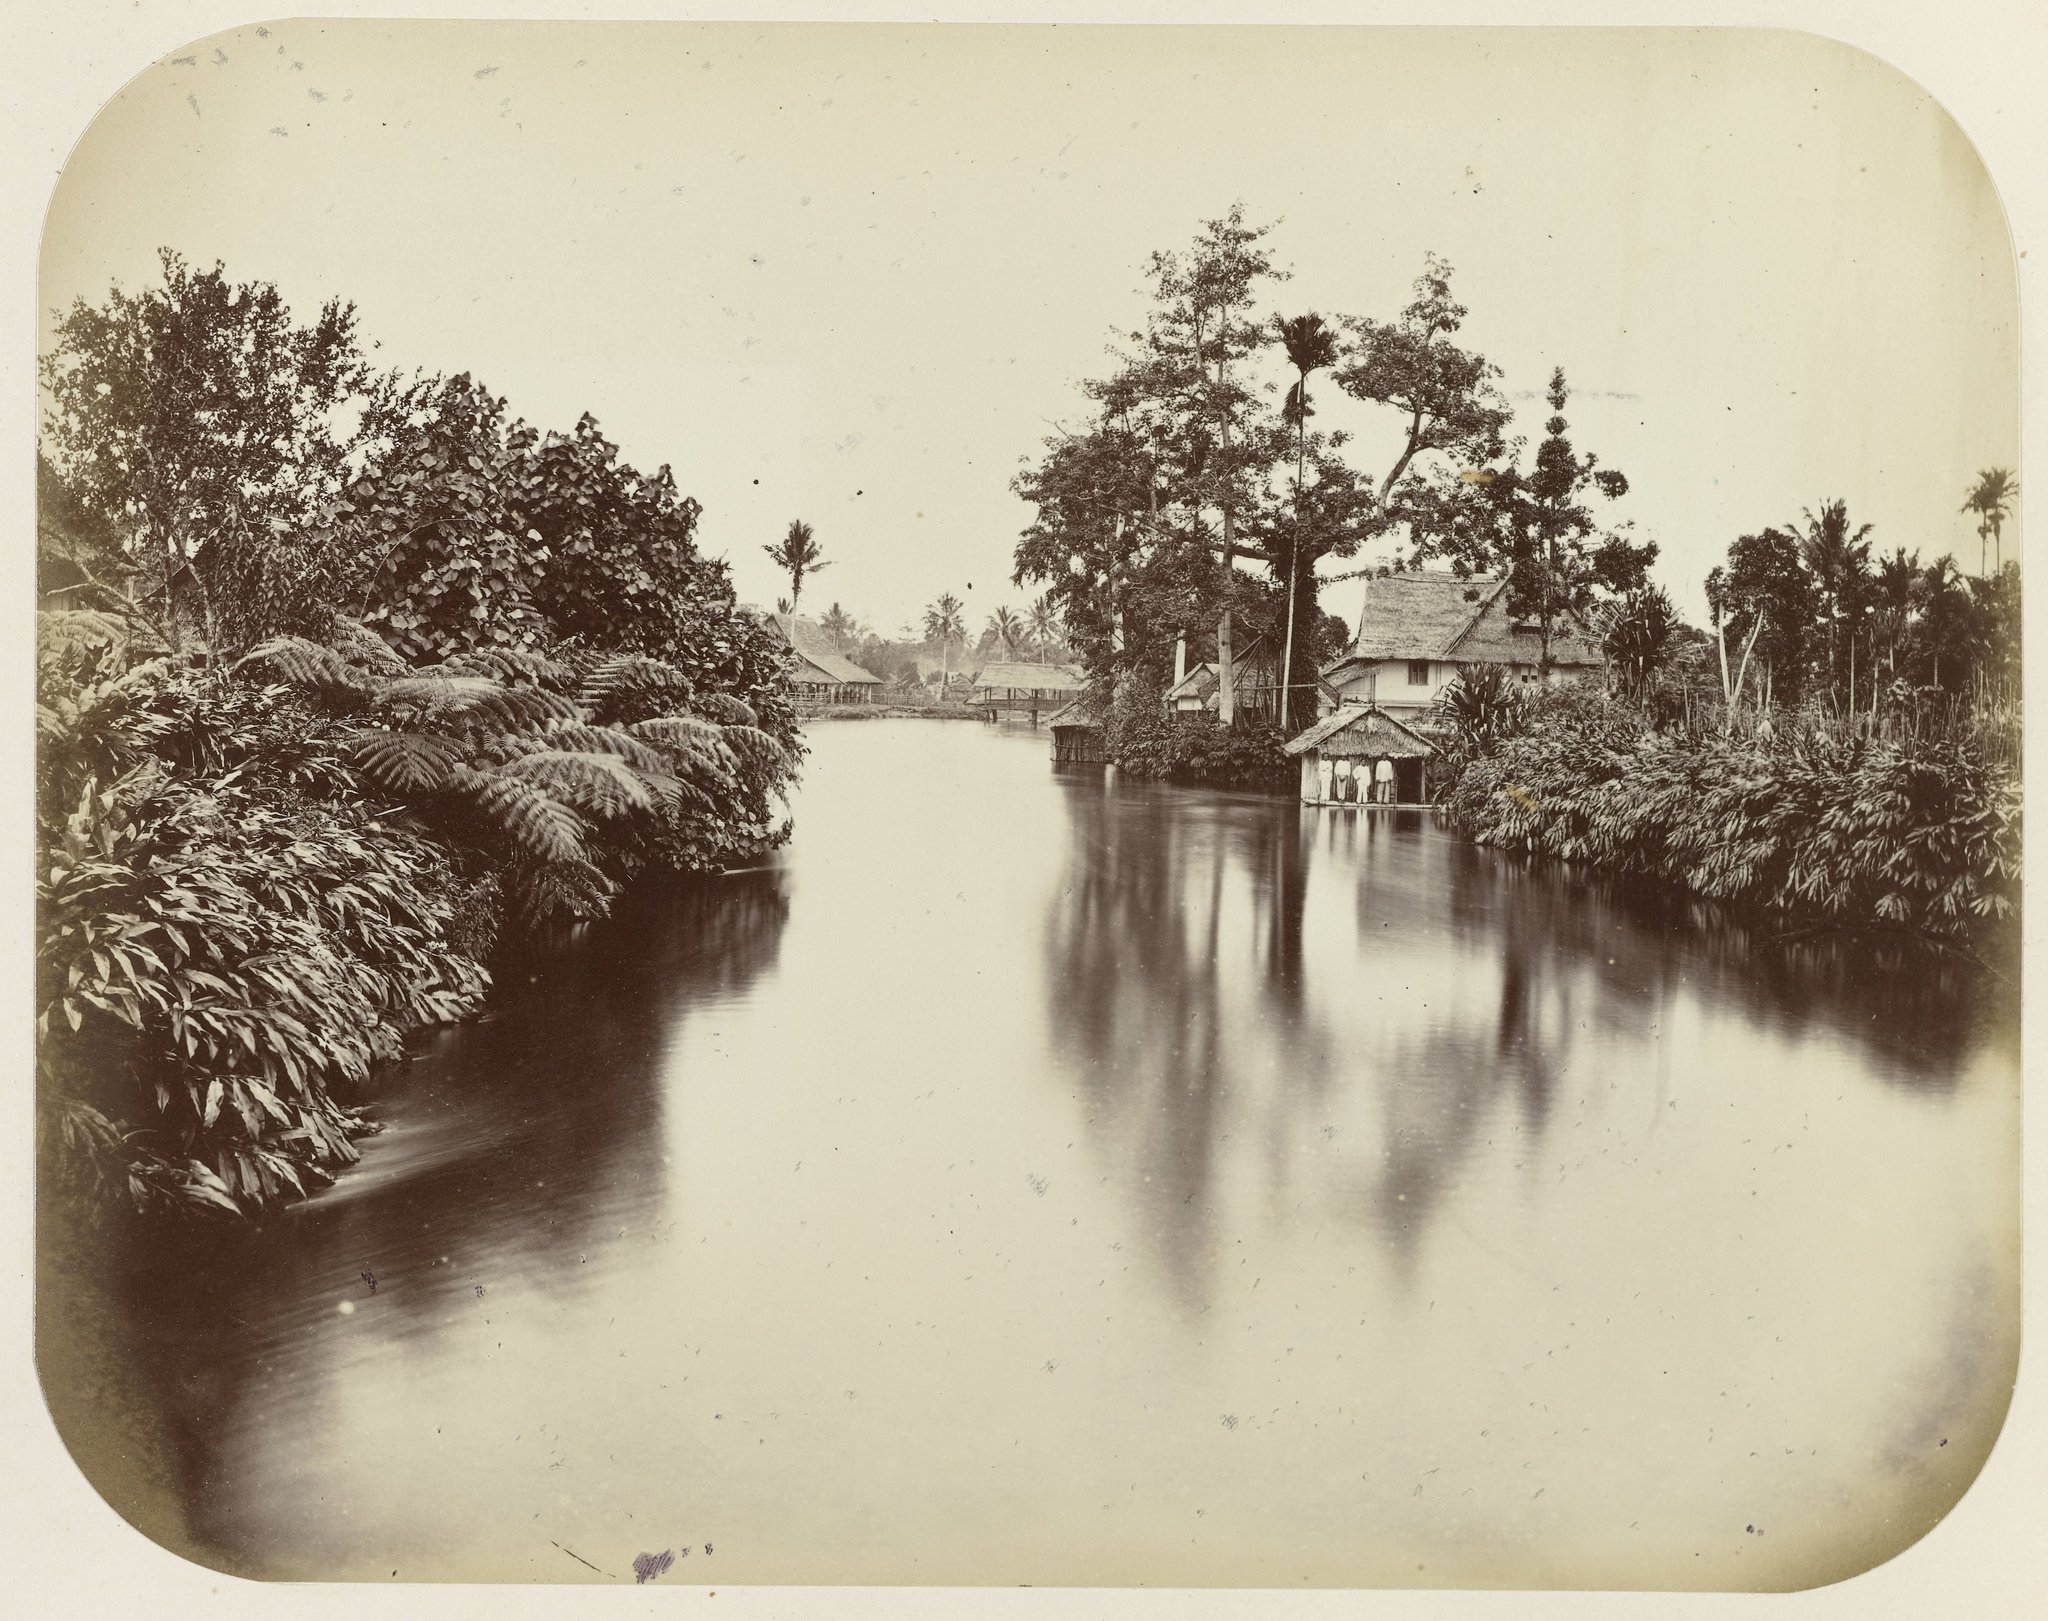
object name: photograph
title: Huizen aan de Tondano te Manado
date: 1860-1880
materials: photographic support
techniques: albumen print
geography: celebes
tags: villa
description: Huizen gelegen aan de rivier de Tondano te Manado op Celebes. Ingeplakte foto in het fotoalbum getiteld: Gezichten van Java.